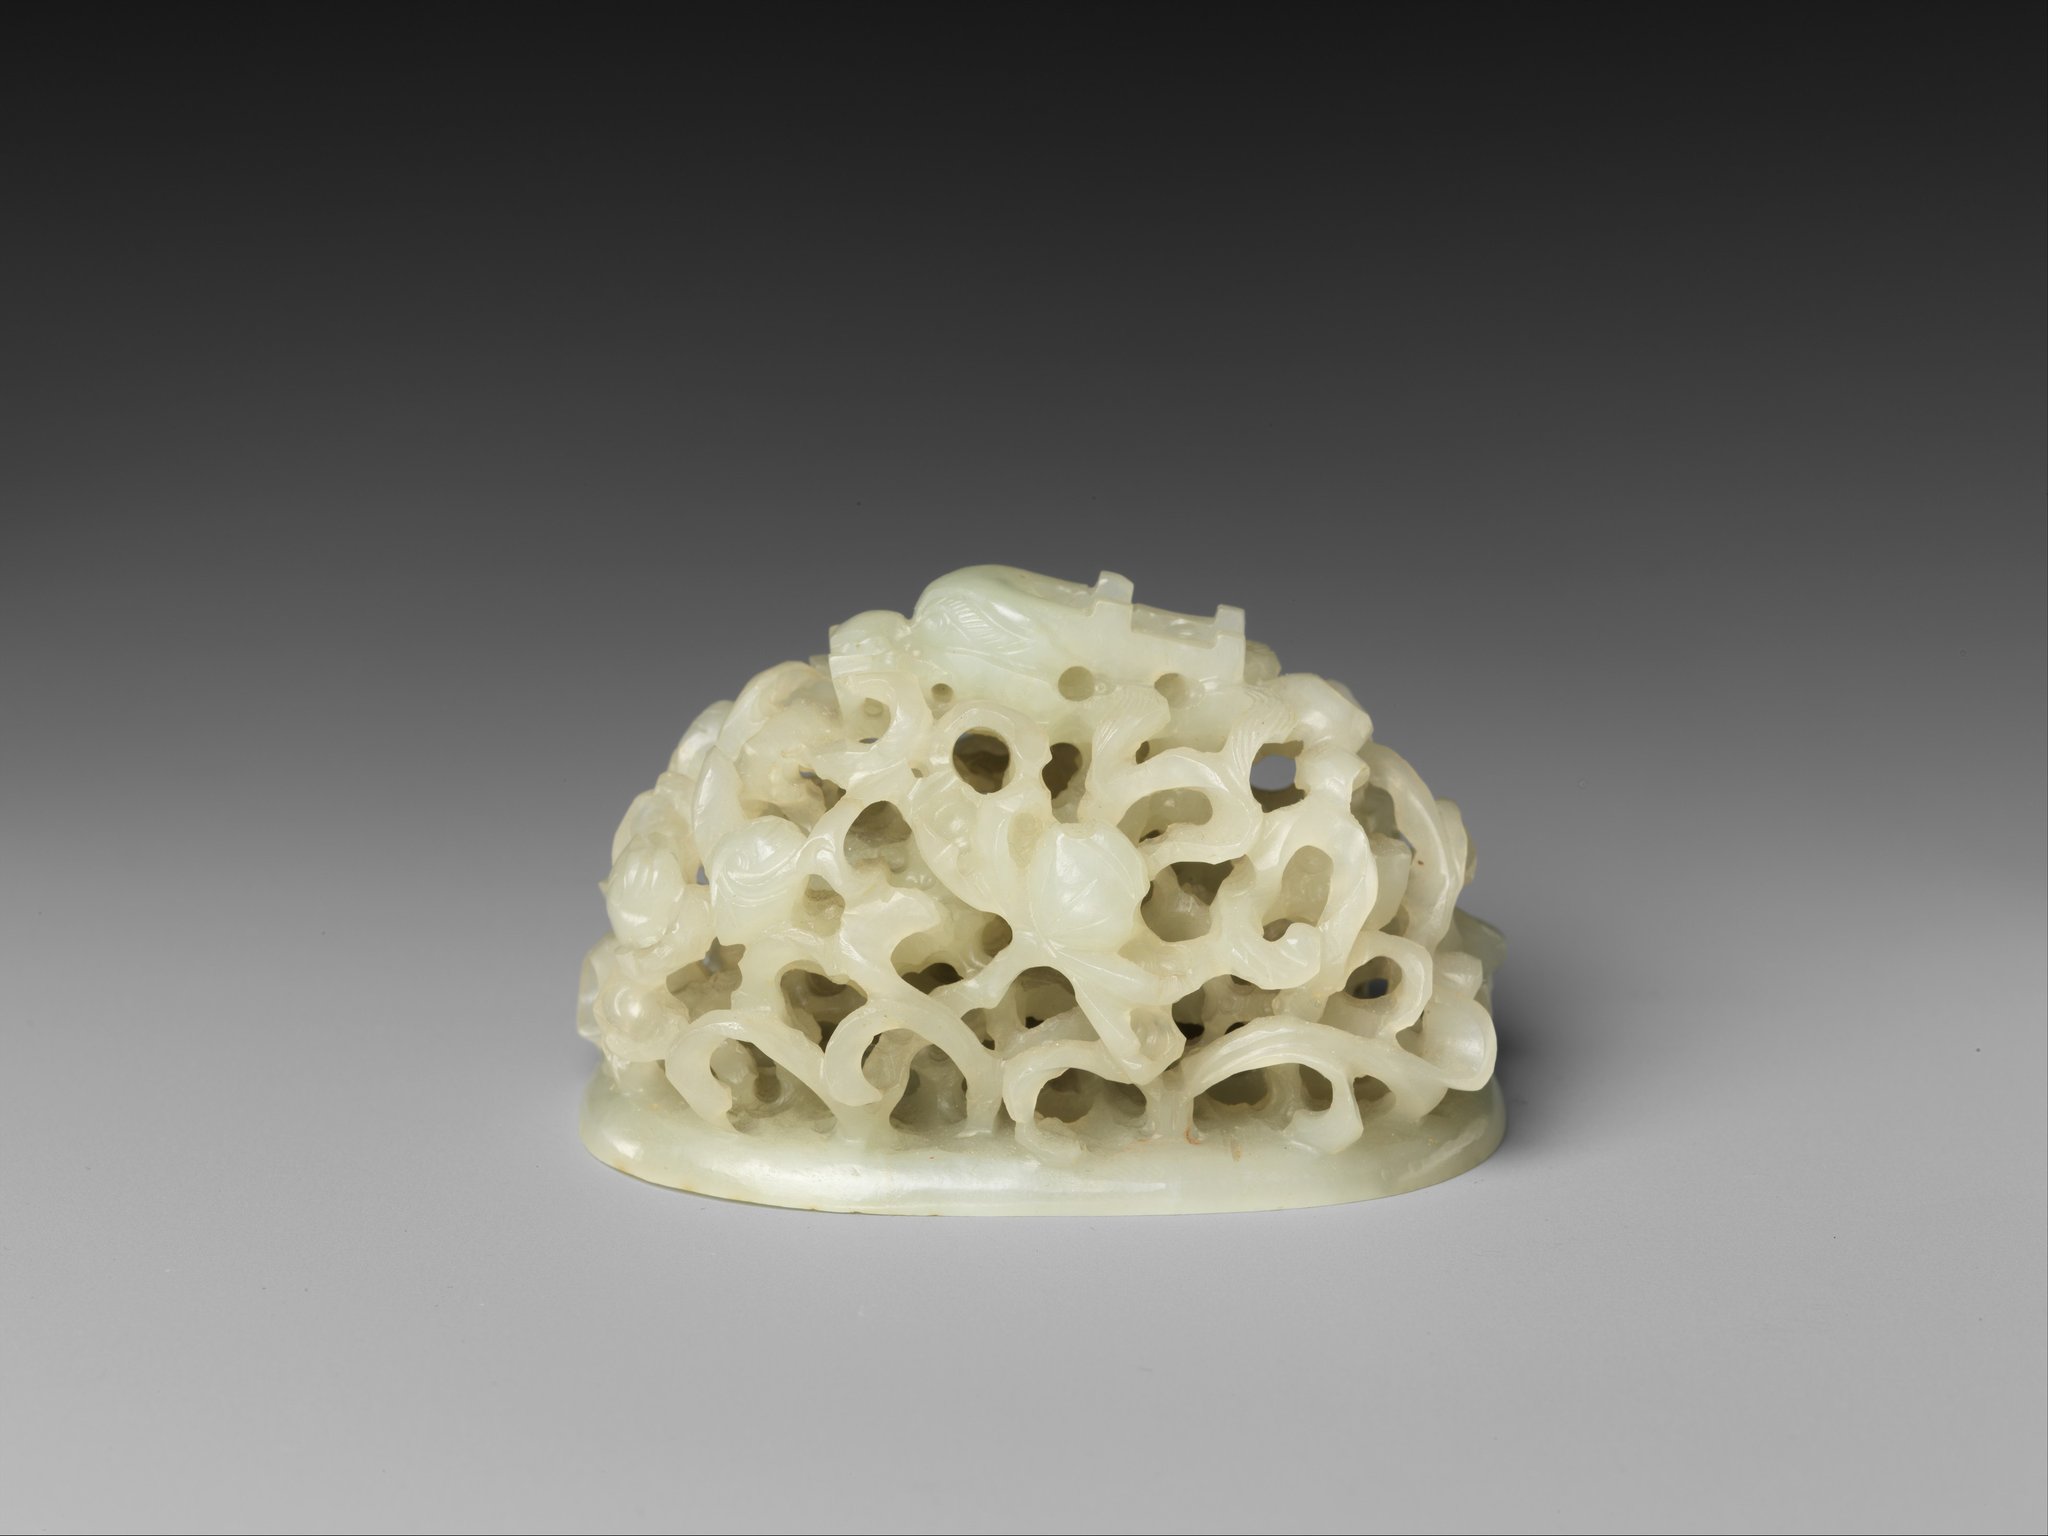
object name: headdress ornament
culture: chinese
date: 1301-1600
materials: jade